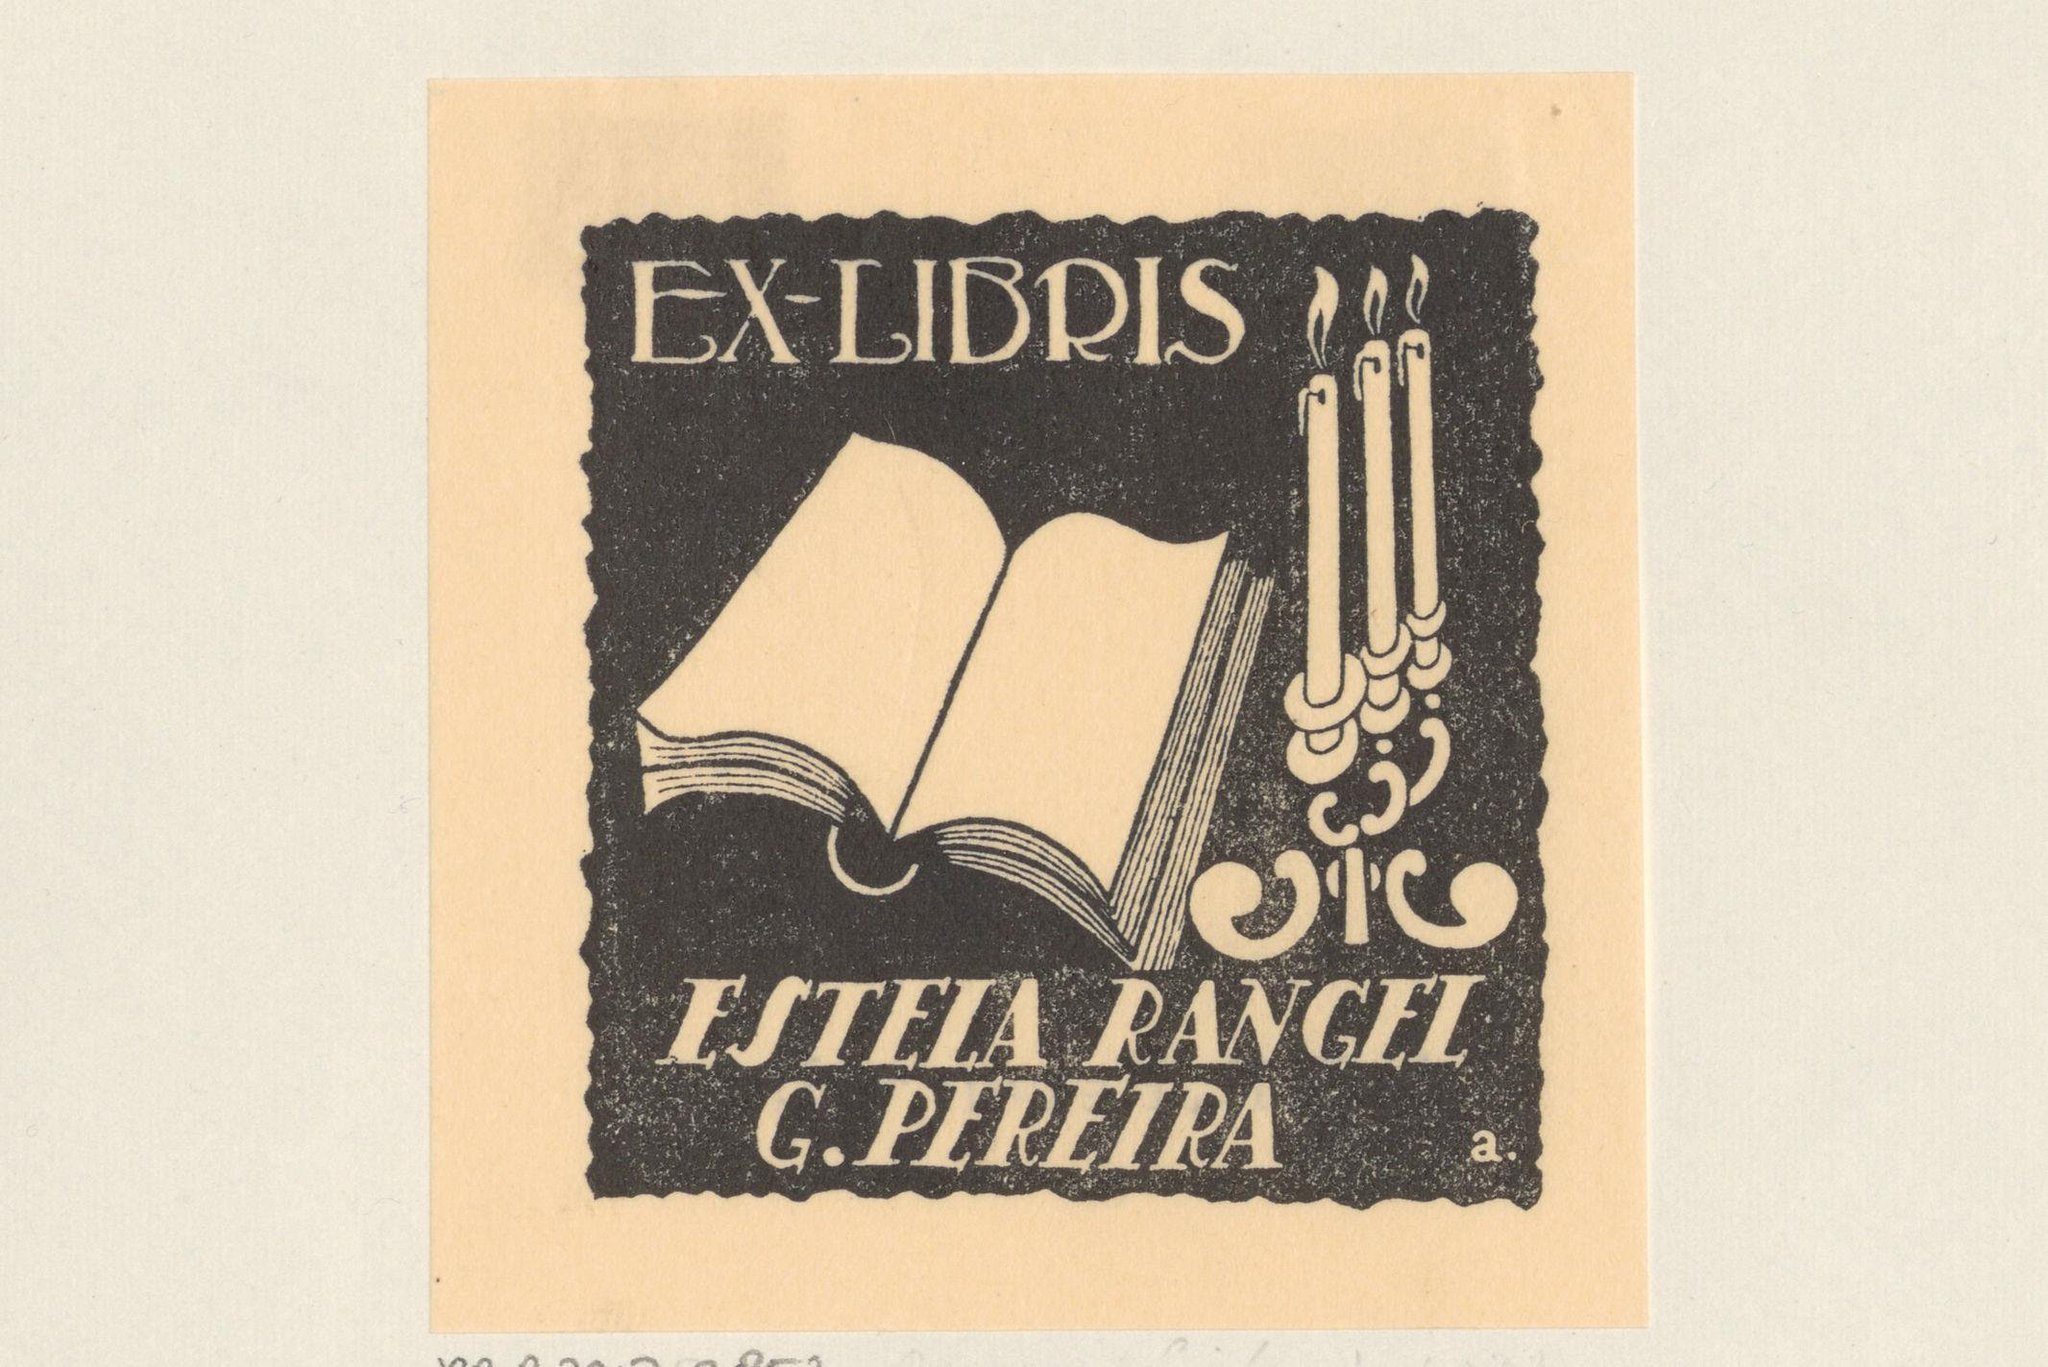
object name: bookplate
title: Ex libris van Estela Rangel G. Pereira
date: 1933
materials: paper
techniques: printing block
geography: portugal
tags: book, candle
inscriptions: workshop stamp: ‘A.G.R. Pereira 1933’